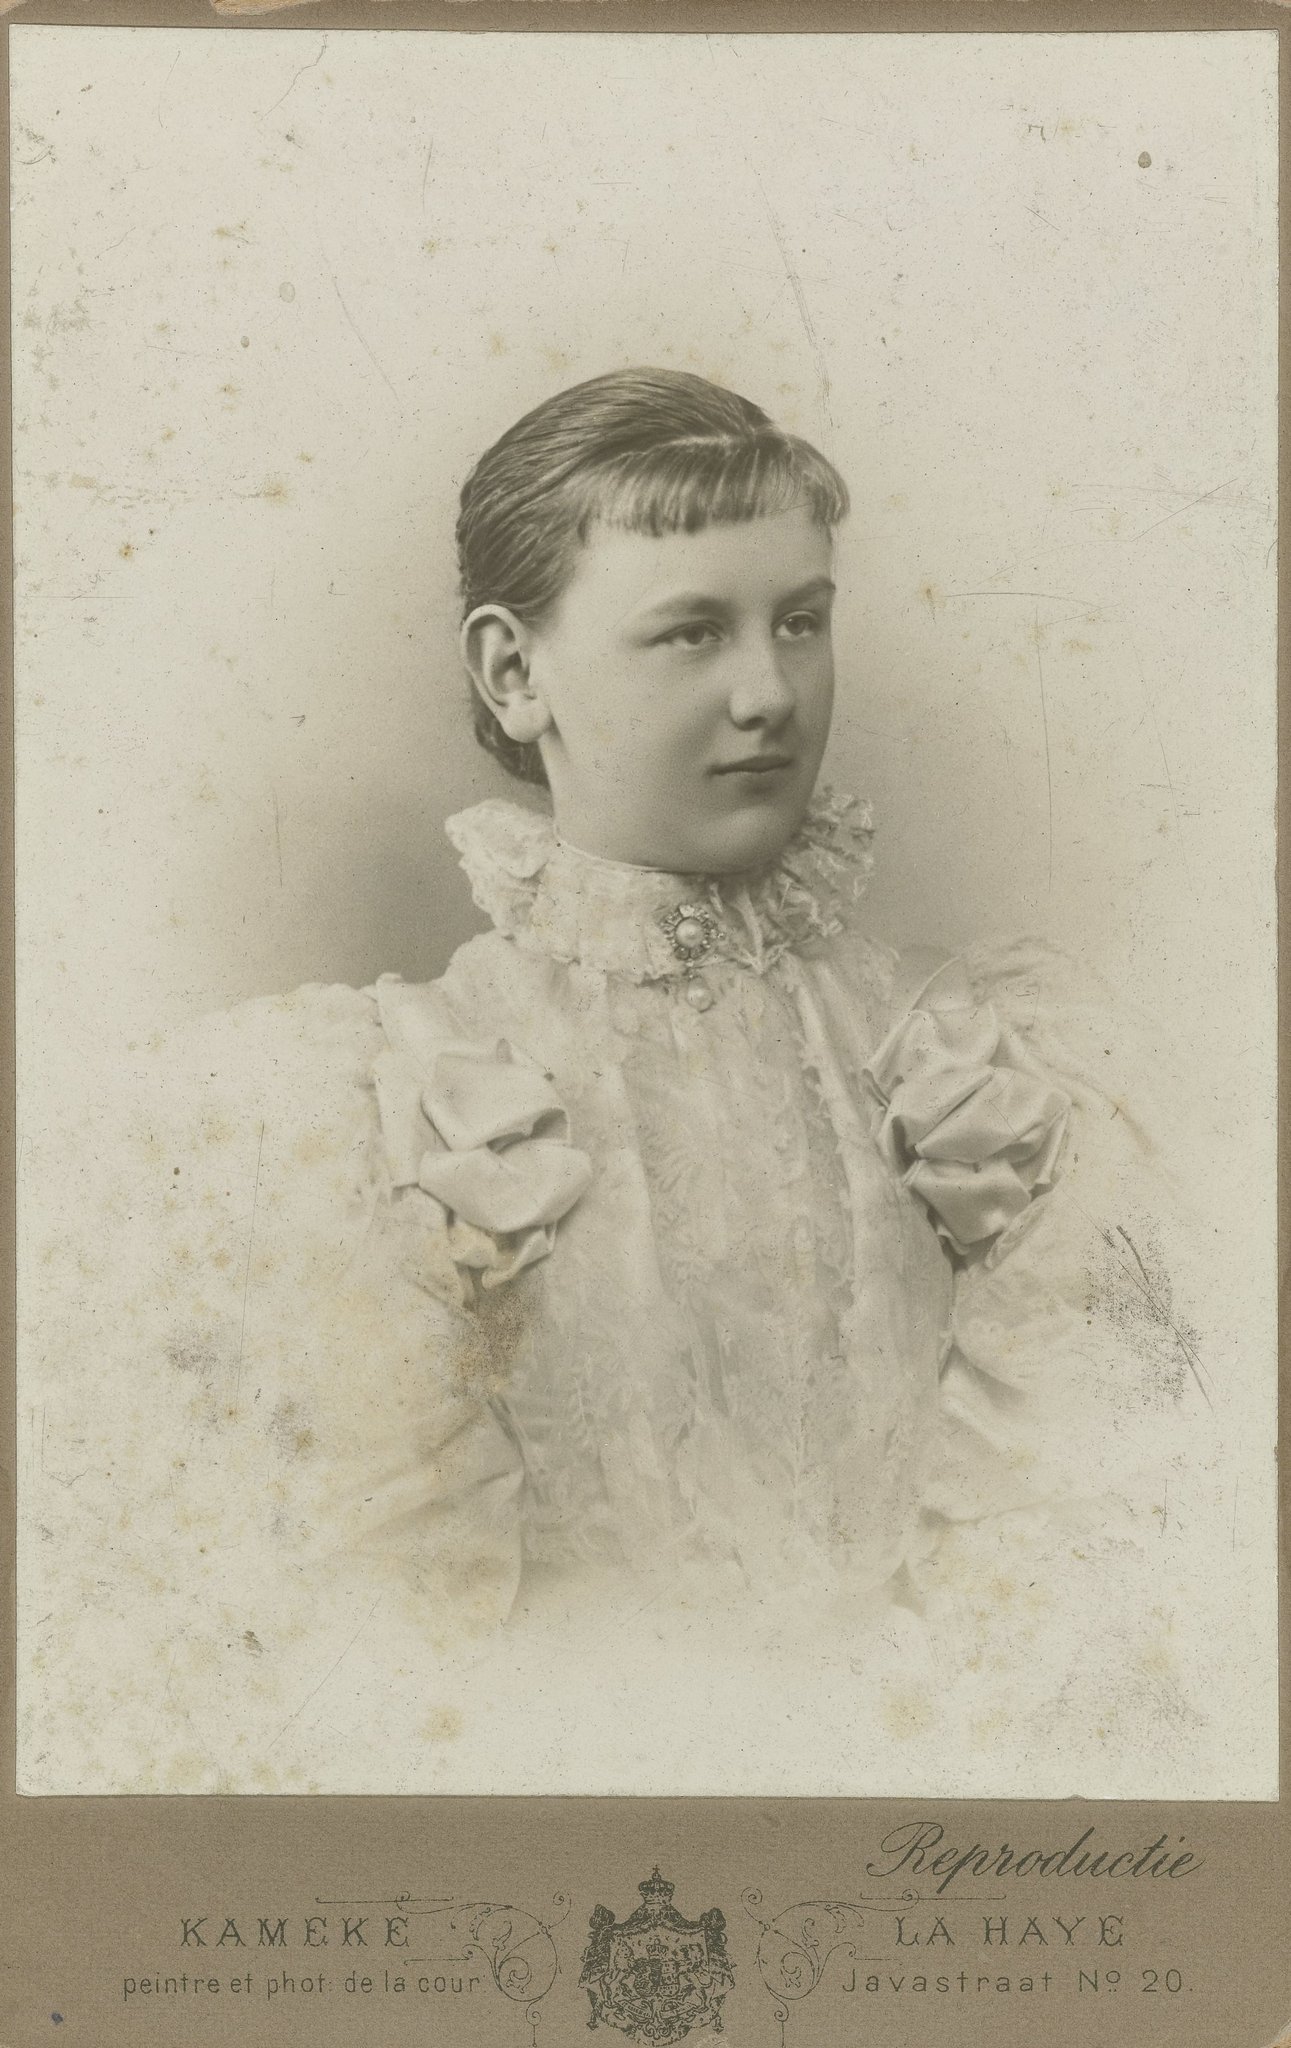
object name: photograph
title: H.M. Koningin Wilhelmina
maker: kameke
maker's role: painter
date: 1896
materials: cardboard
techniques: photography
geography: the hague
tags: the hague, print maker, wilhelmina of the netherlands, netherlands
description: Foto op dik karton: meisje, half figuur naar rechts. Foto van koningin Wilhelmina. Merk. Keerzijde: plakkertje: 'J. Meeussen & Fils'. Opschrift; voorz.: 'Reproductie Kameke La Haye peintre et phot. de la cour Javastraat No 20'.